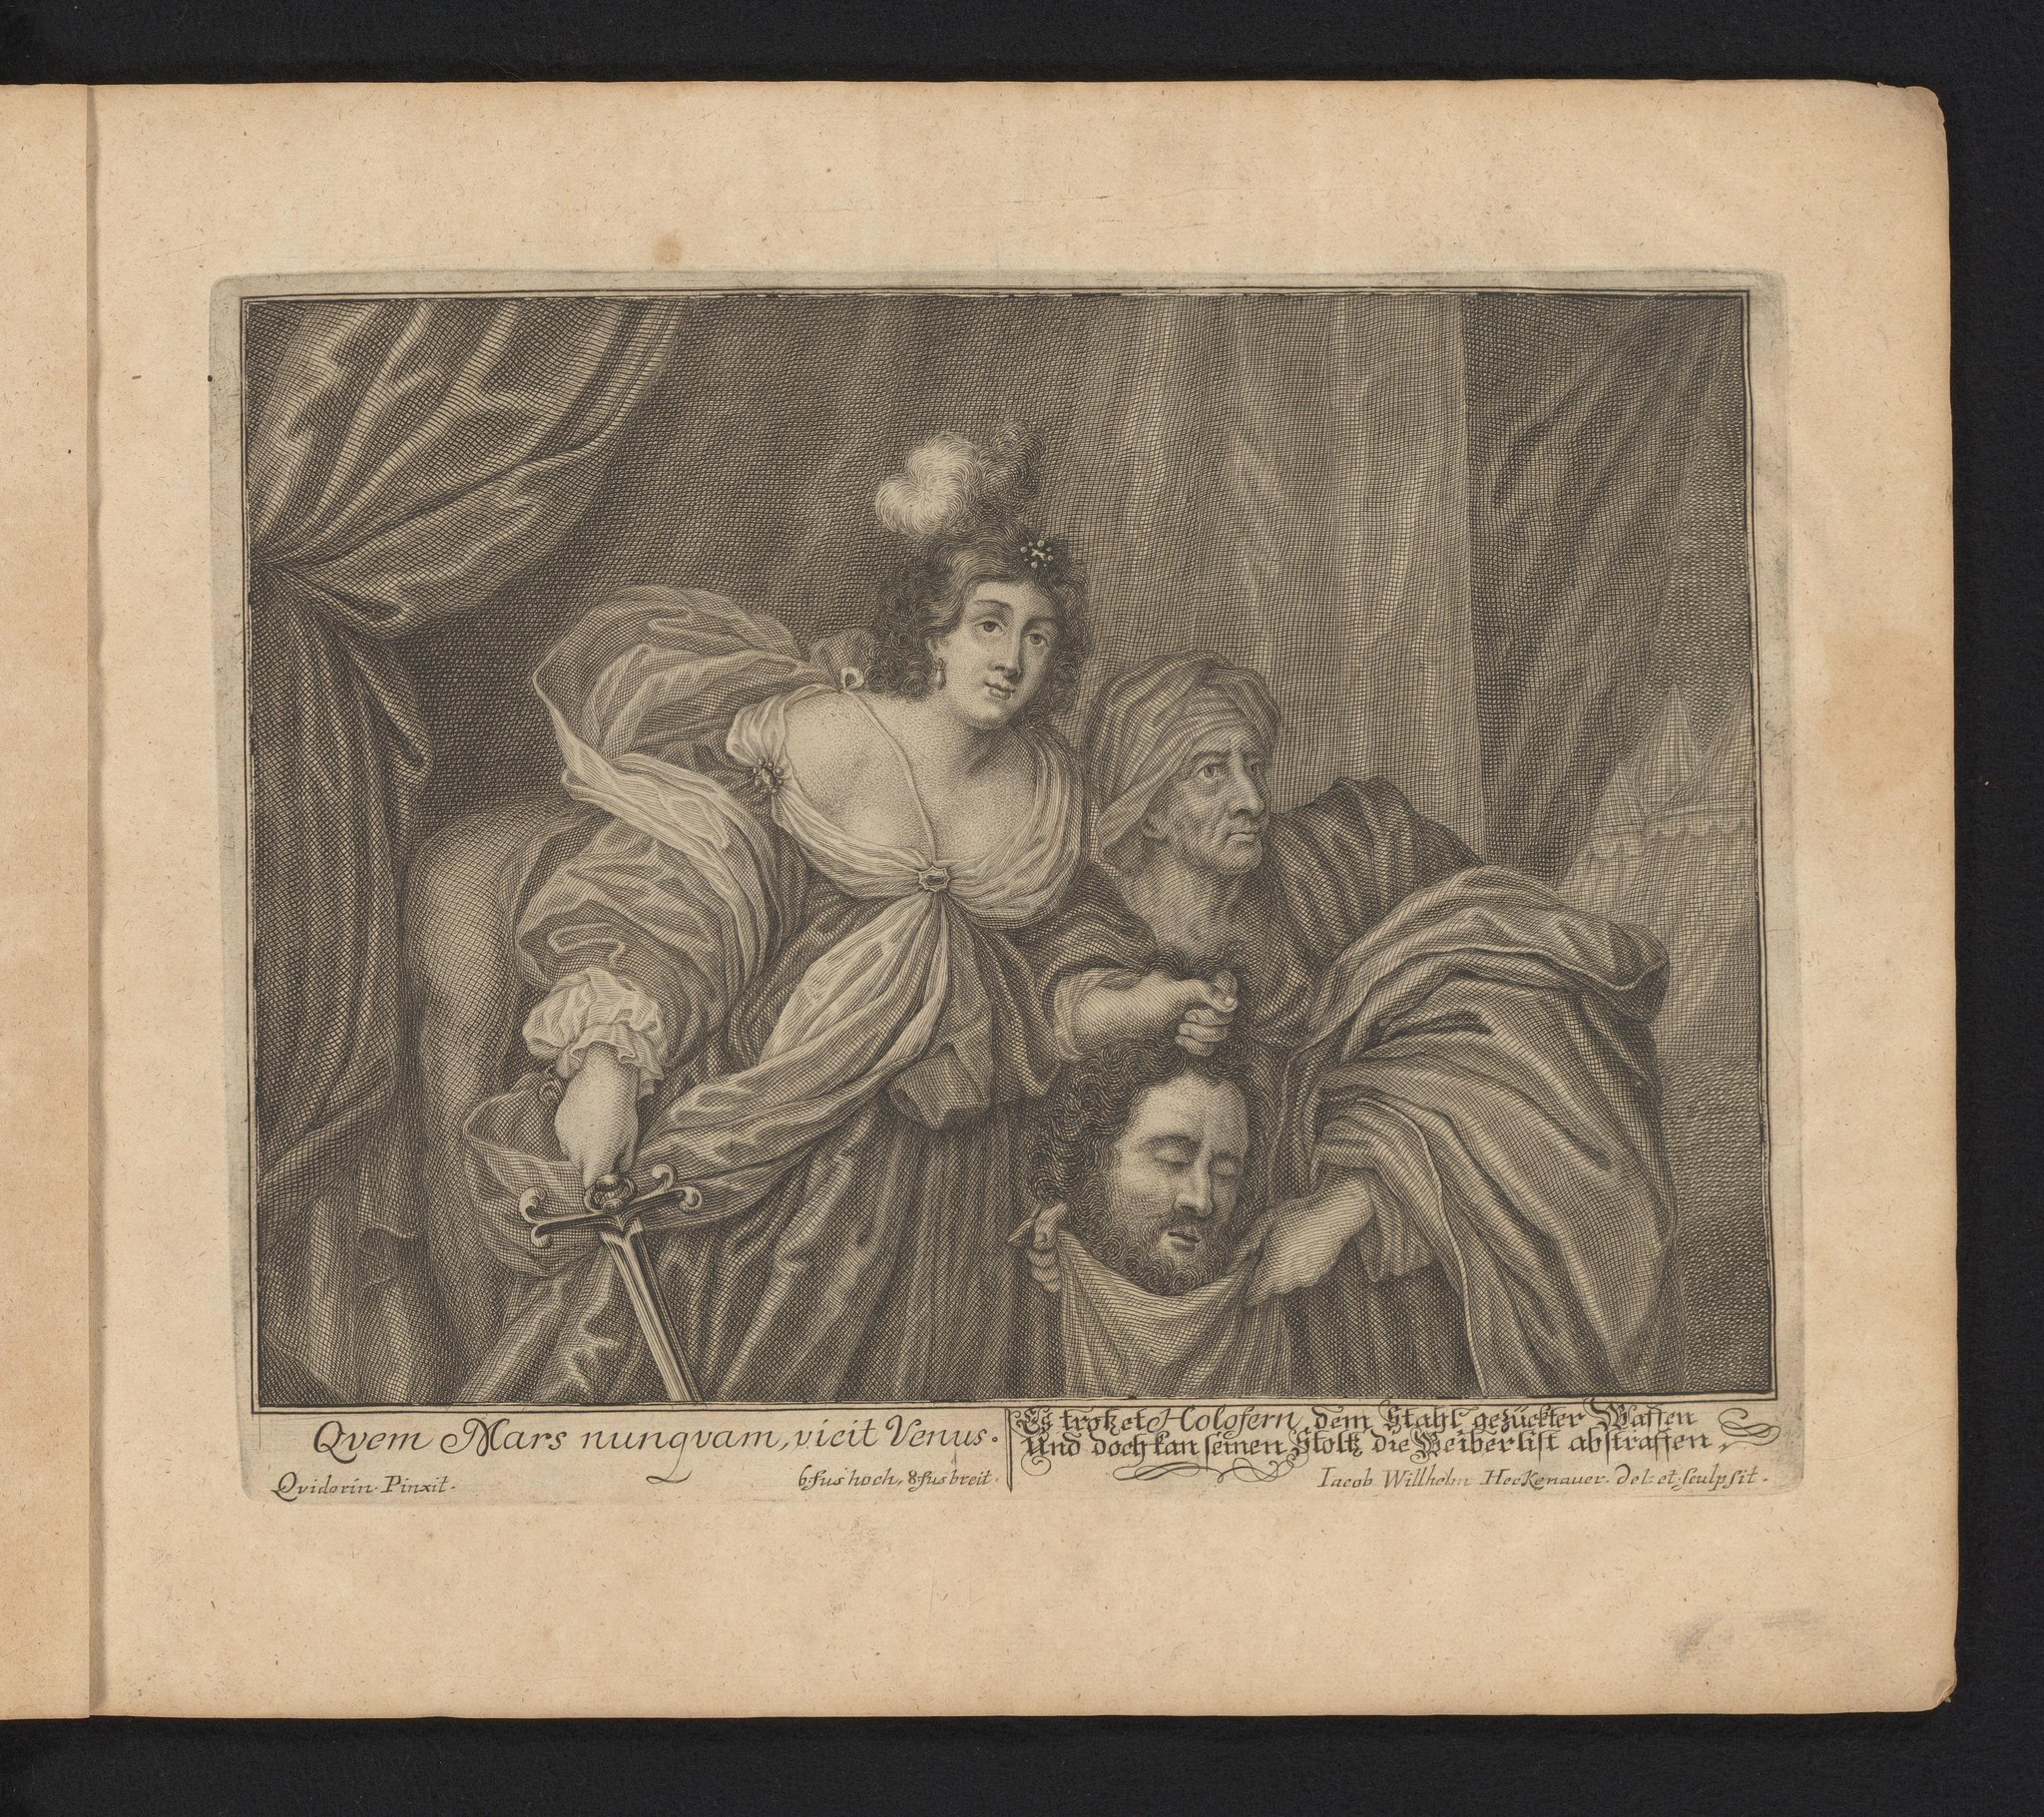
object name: album leaf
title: Judit met het hoofd van Holofernes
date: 1710-1714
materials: paper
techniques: engraving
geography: wolfenbüttel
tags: judith and her maidservant put holofernes' head in a sack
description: Tekst in het Duits en het Latijn in de ondermarge. Prent maakt deel uit van een album.